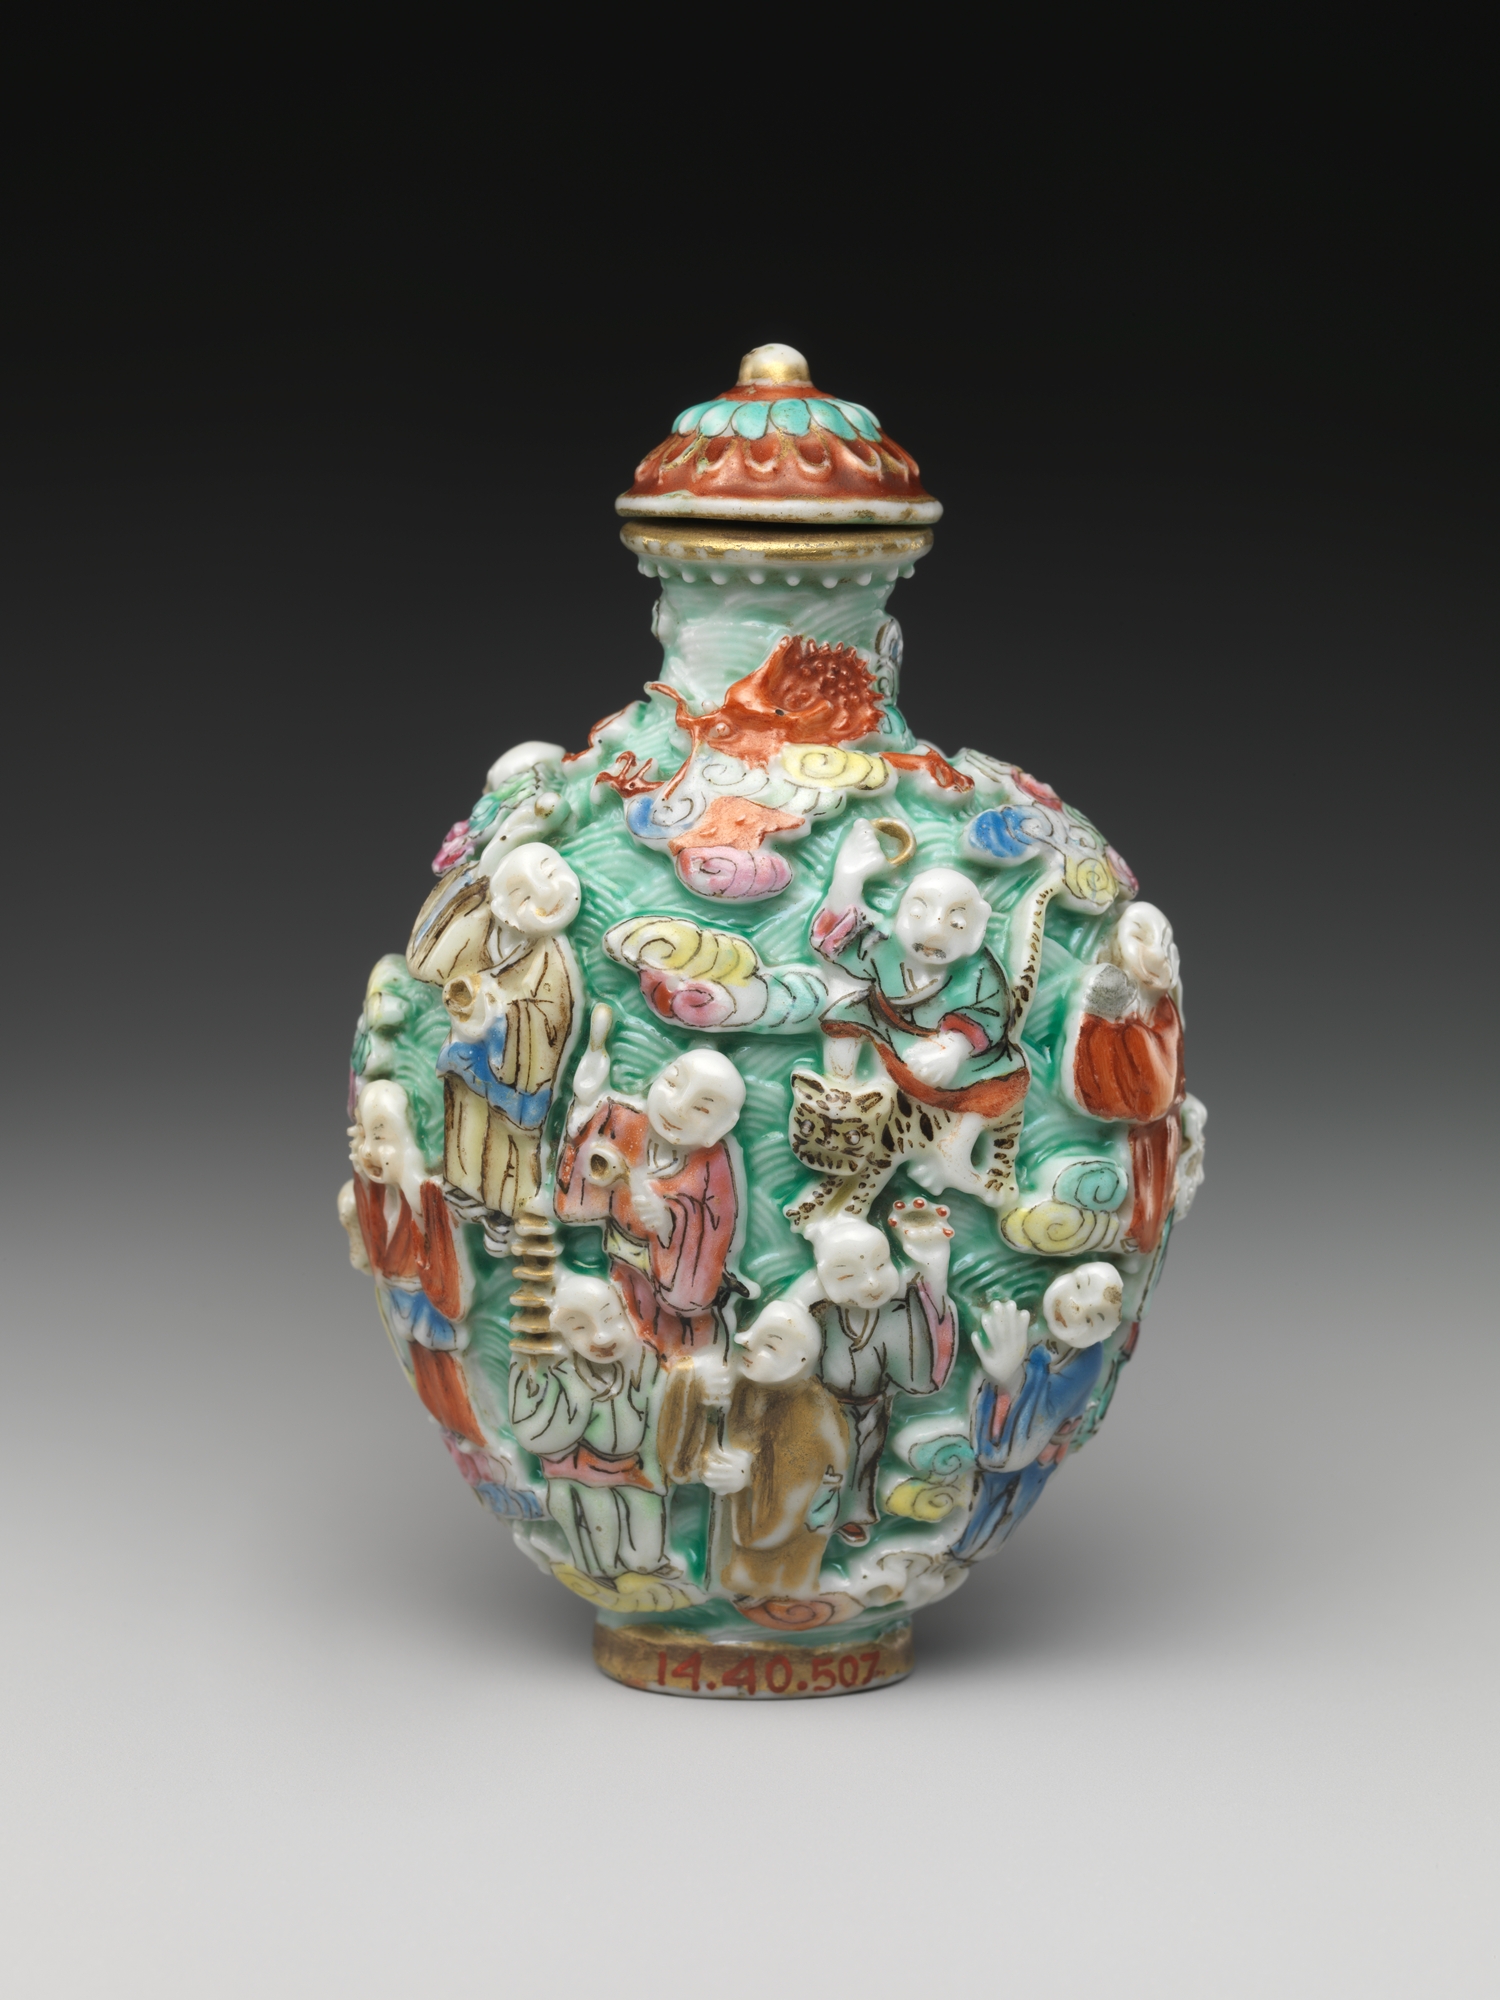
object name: snuff bottle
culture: chinese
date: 1796-1820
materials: porcelain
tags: human figures,animals